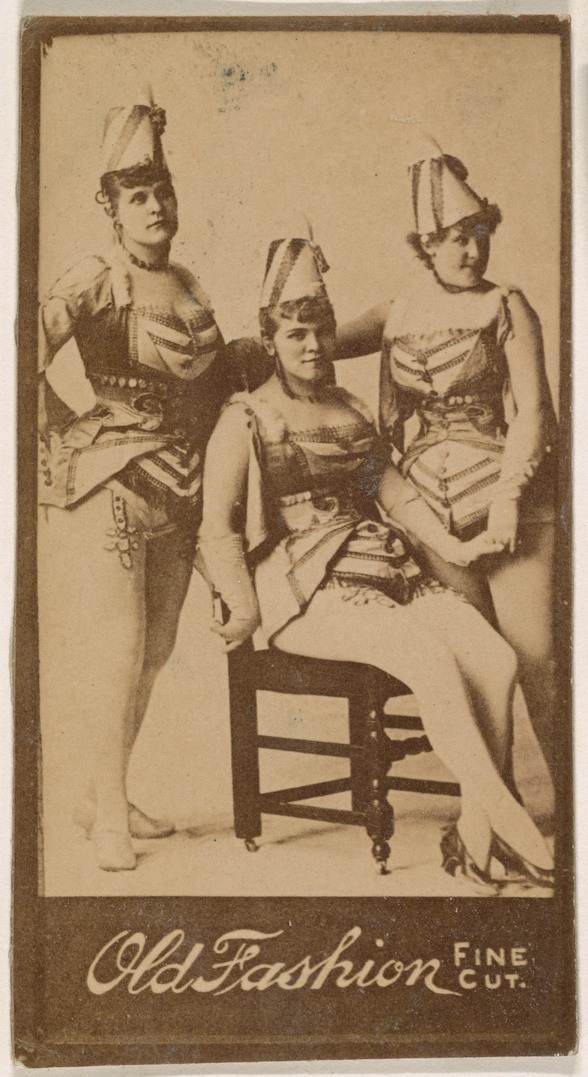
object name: photograph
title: Trio of actresses, from the Actresses series (N664) promoting Old Fashion Fine Cut Tobacco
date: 1888-1890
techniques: albumen silver print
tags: portraits,women,actresses